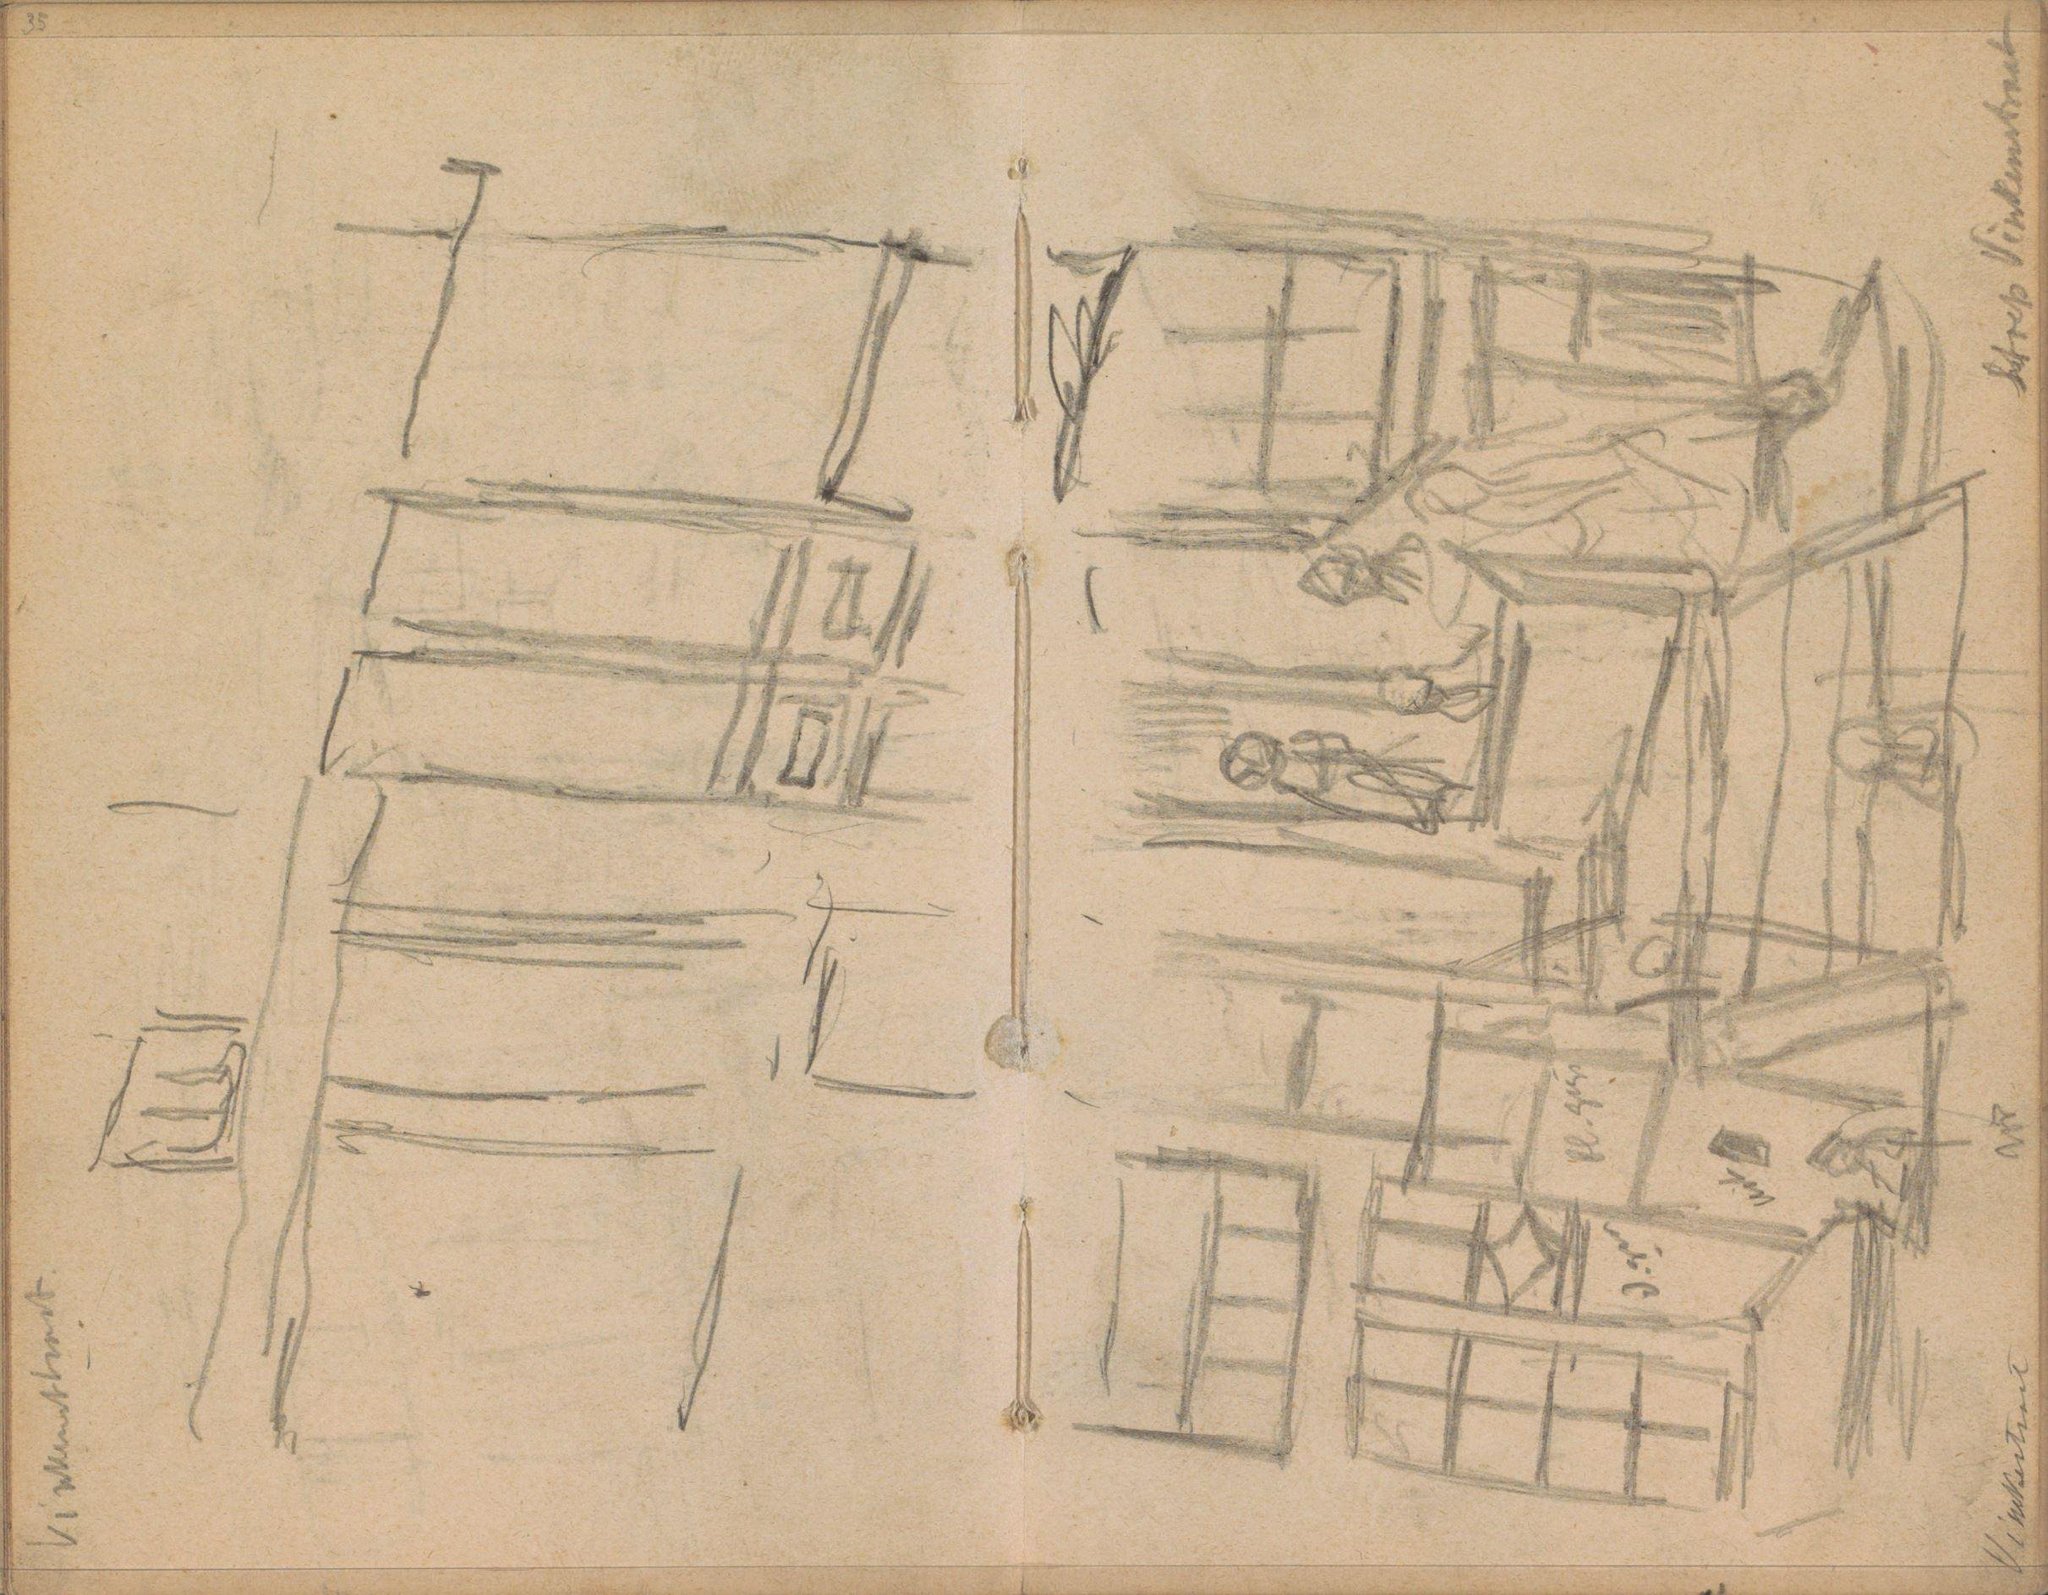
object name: sketchbook leaf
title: Gezicht op een bordes in de Vinkenstraat te Amsterdam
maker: george hendrik breitner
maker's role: draughtsman, painter, print maker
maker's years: 1857-1923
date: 1902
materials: paper, pencil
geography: amsterdam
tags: urban housing, street (+ city(-scape) with figures, staffage)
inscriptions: annotation: ‘Vinkenstraat/ Vinkenstraat/ Stoep Vinkenstraat’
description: Pagina 35 en pagina 36 uit een schetsboek met 46 bladen vervaardigd in de omgeving van Amsterdam, Rotterdam en Haarlem.